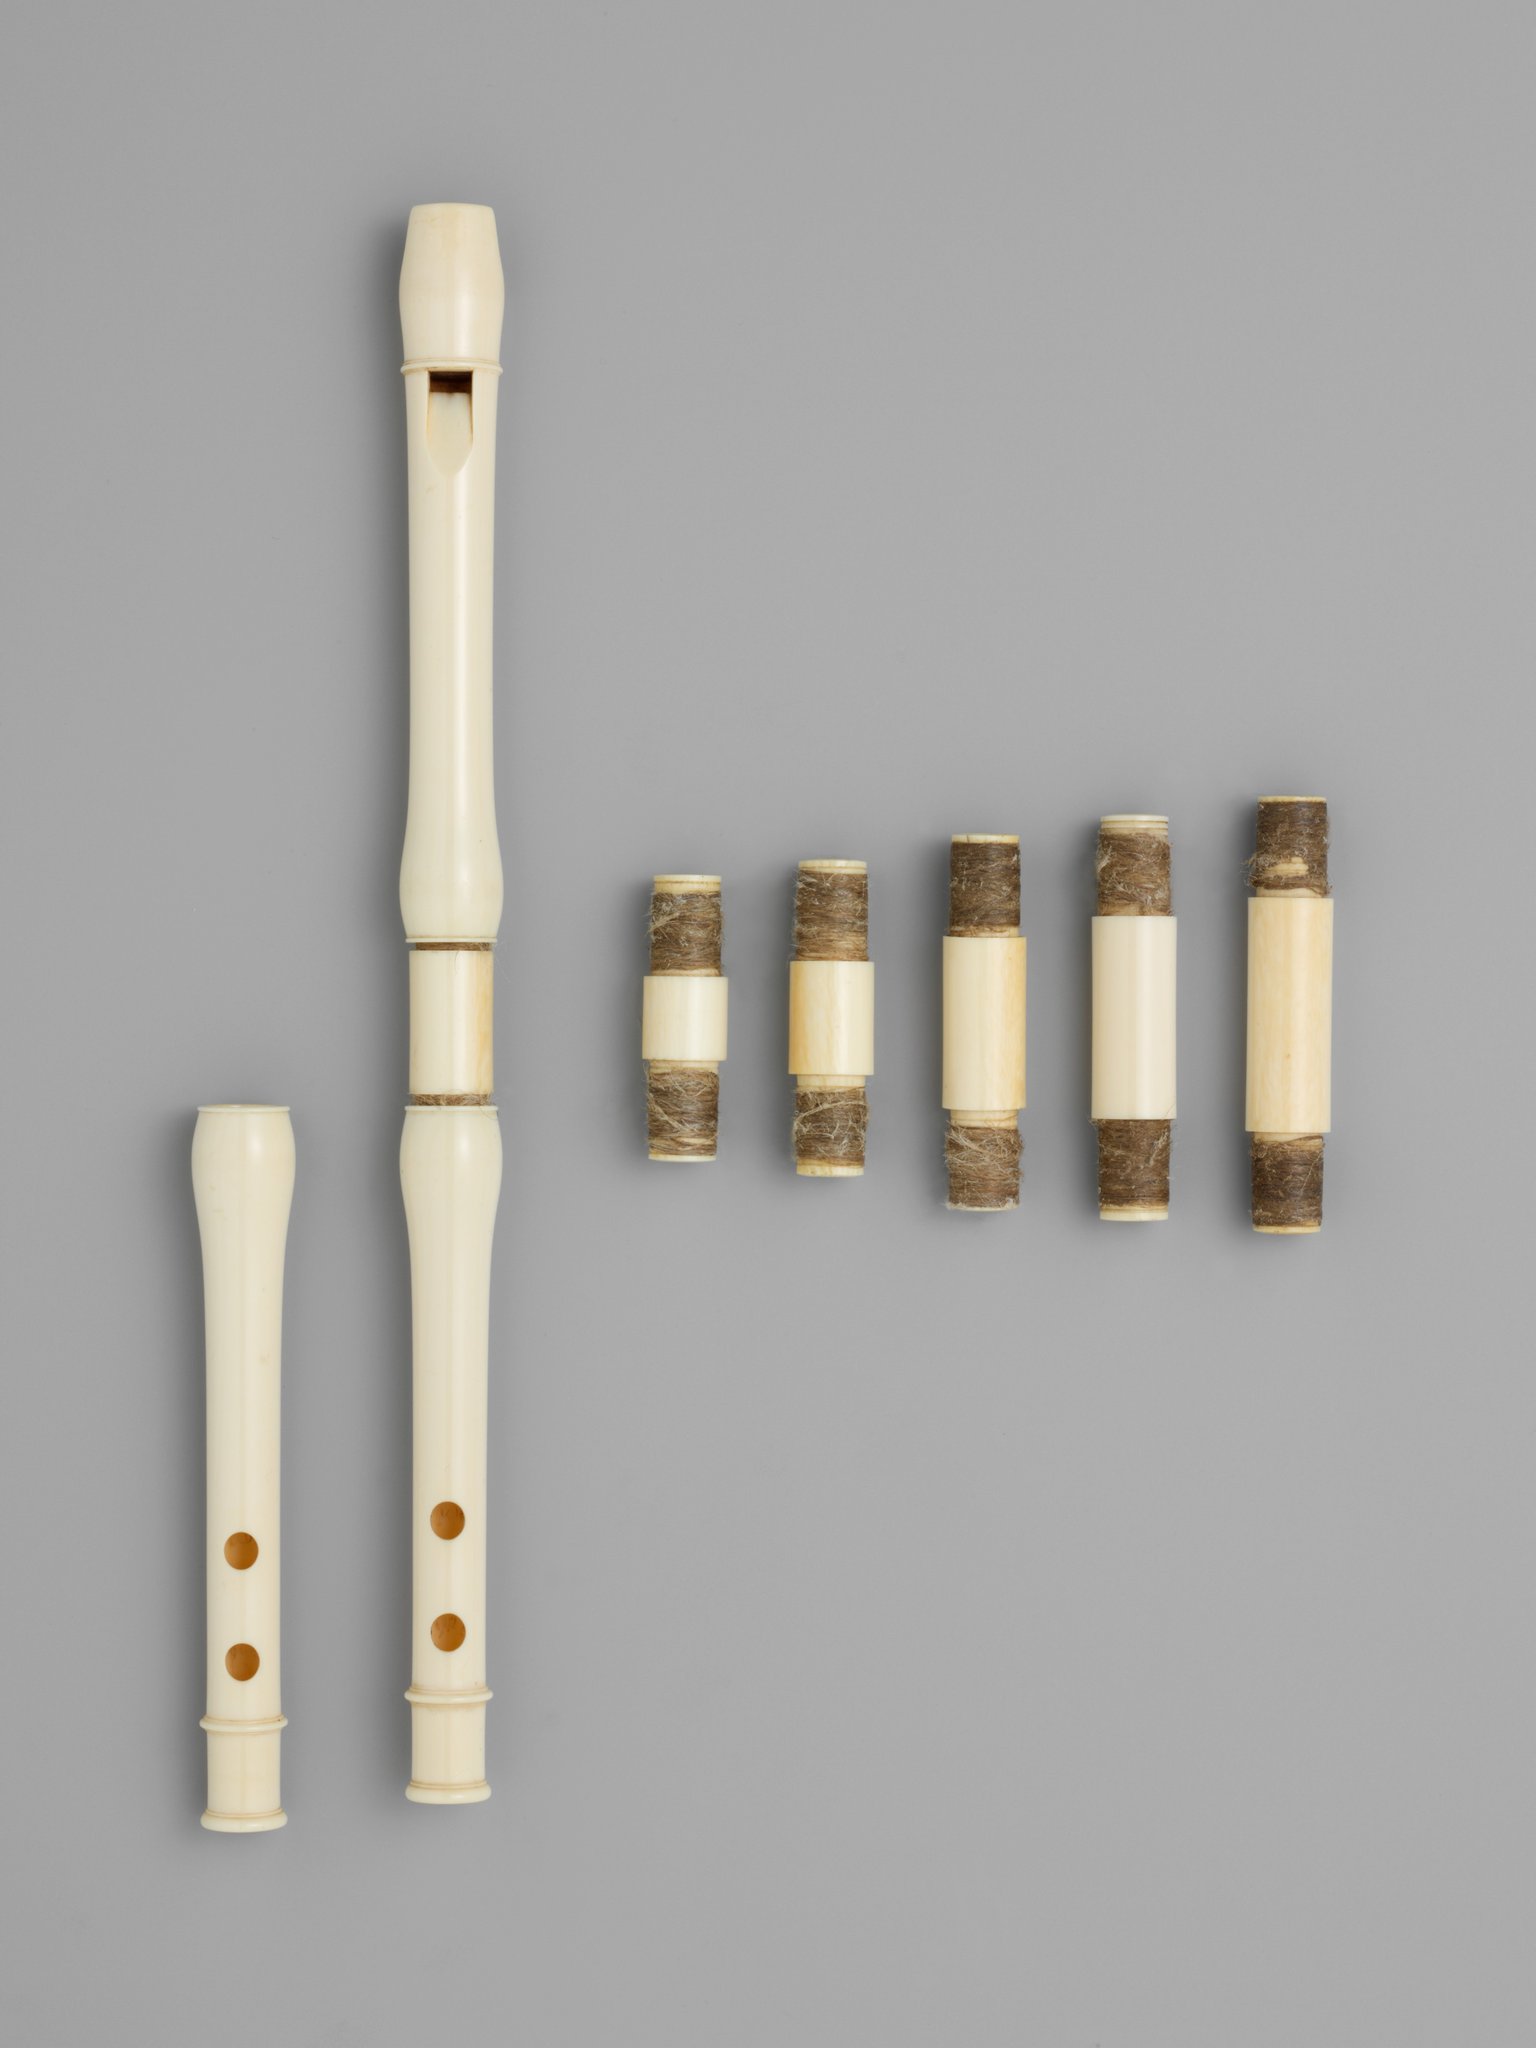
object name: galoubet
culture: french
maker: gilles lot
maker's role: maker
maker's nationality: french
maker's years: 1721-1775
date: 1770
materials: ivory, leather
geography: france